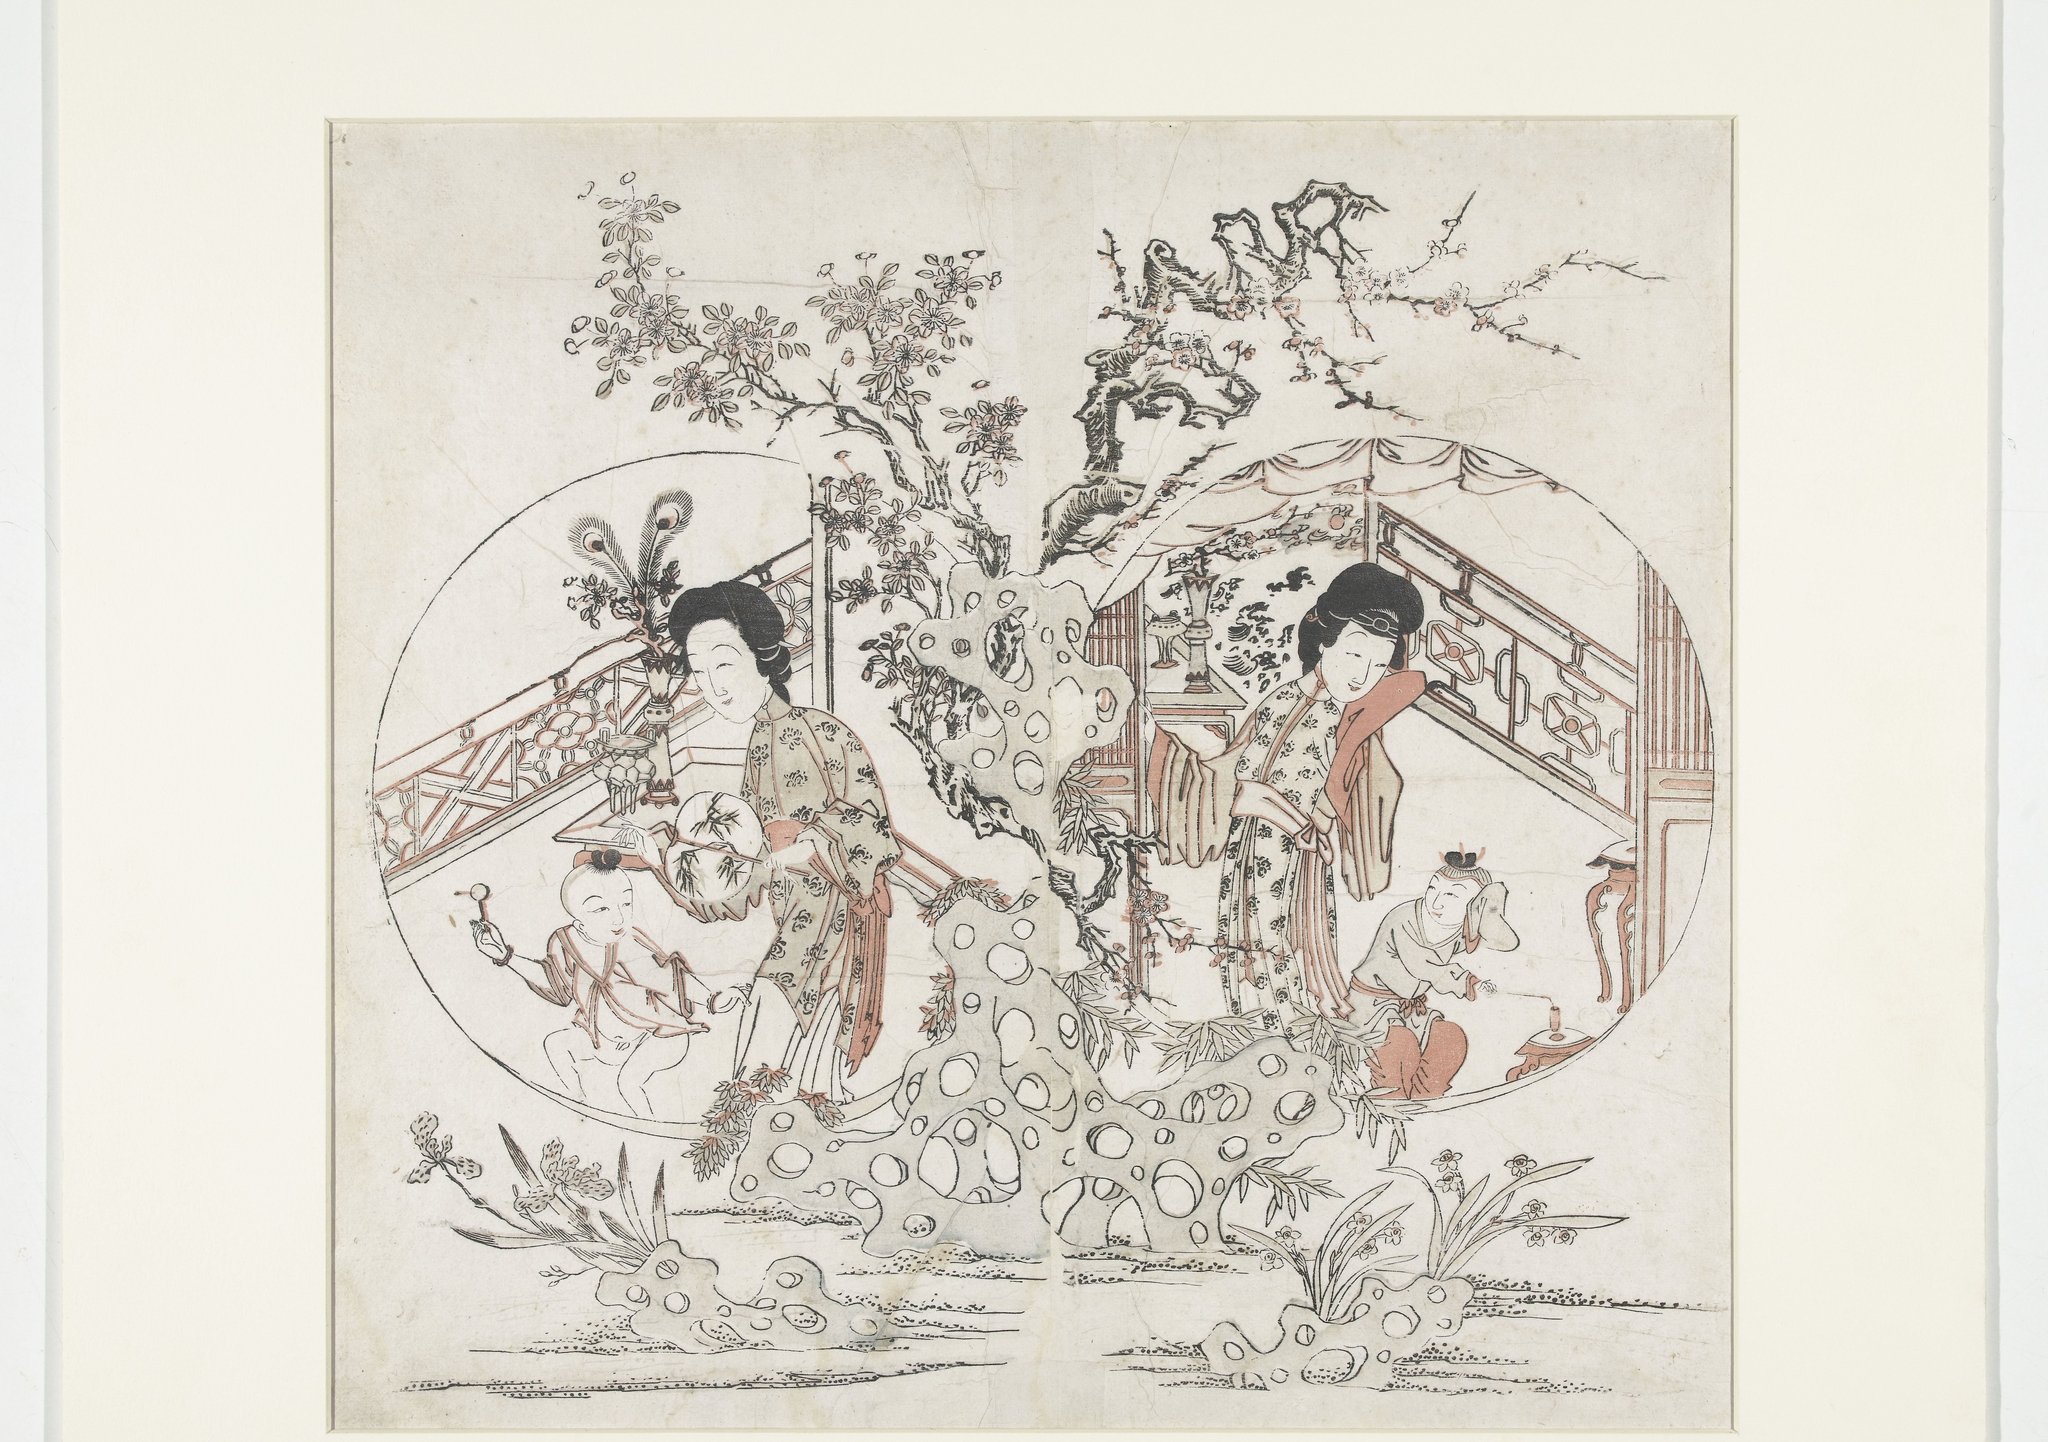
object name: print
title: Uit twee delen bestaande prent, voorstellende: links de zomer met iris en malus en rechts de winter met narcis en prunus (nieuwjaarsprent)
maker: Anonymous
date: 1650-1725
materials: paper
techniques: woodcut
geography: china